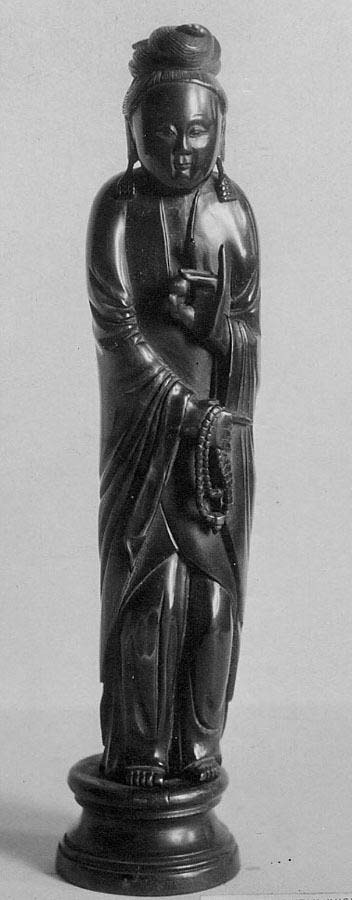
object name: figure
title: Carved Figure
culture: chinese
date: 1662-1722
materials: ivory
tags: men